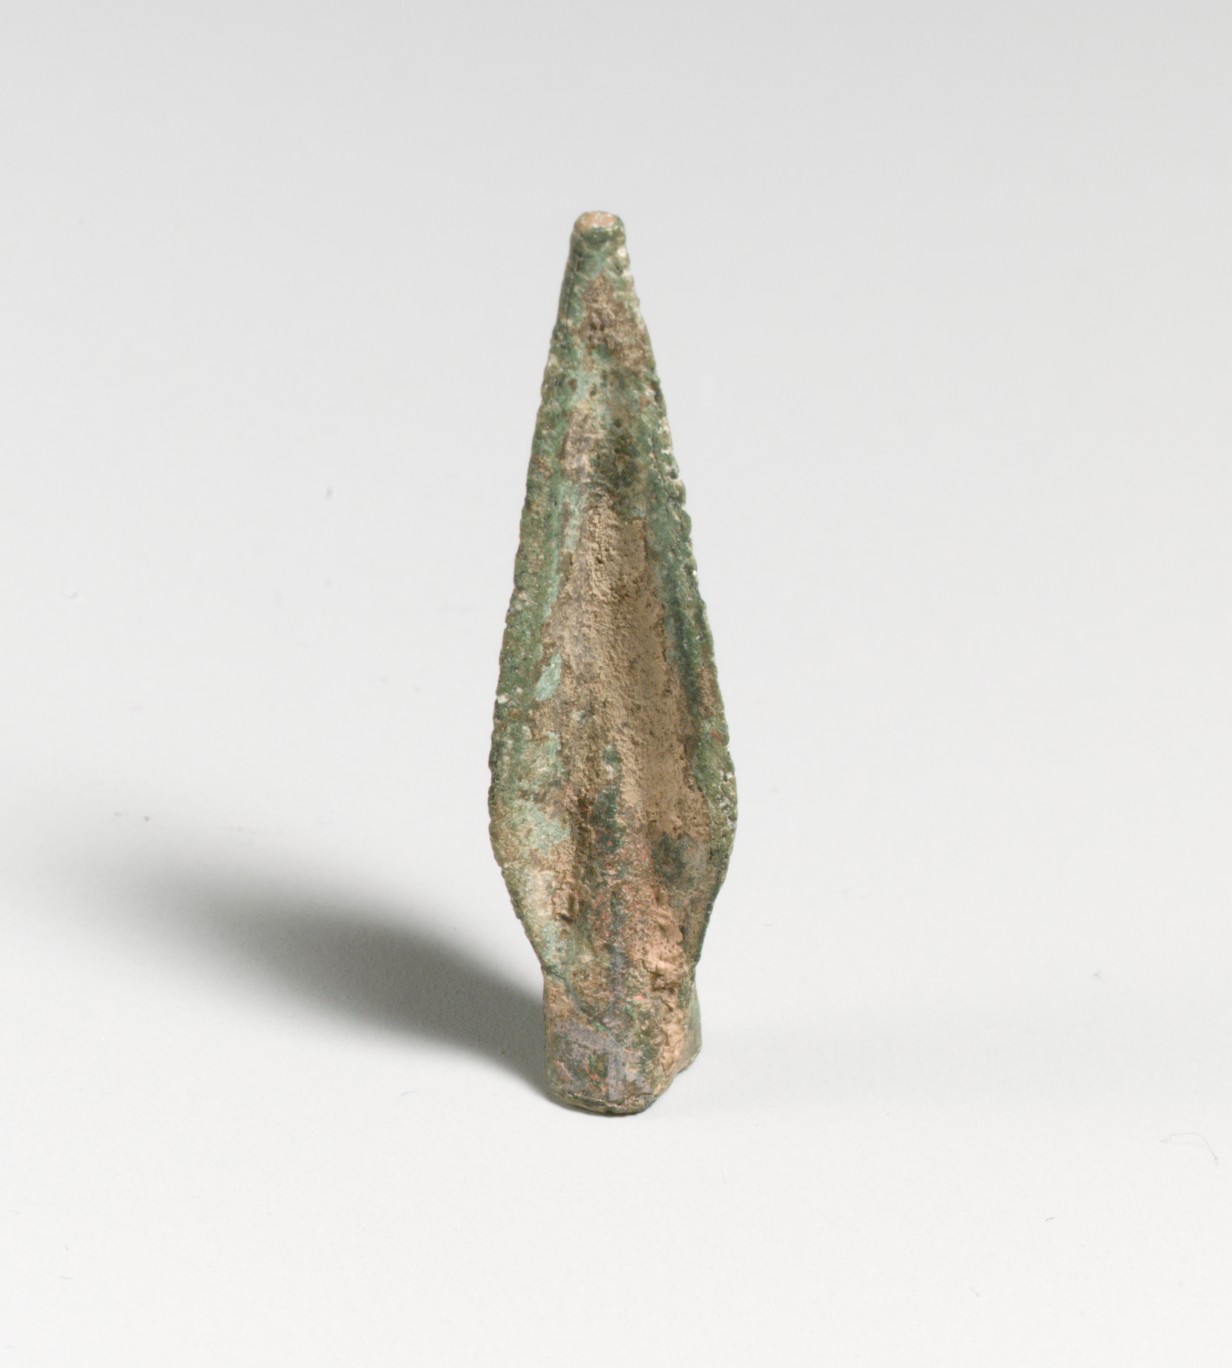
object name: arrowhead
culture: cypriot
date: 480-330 BCE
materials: bronze